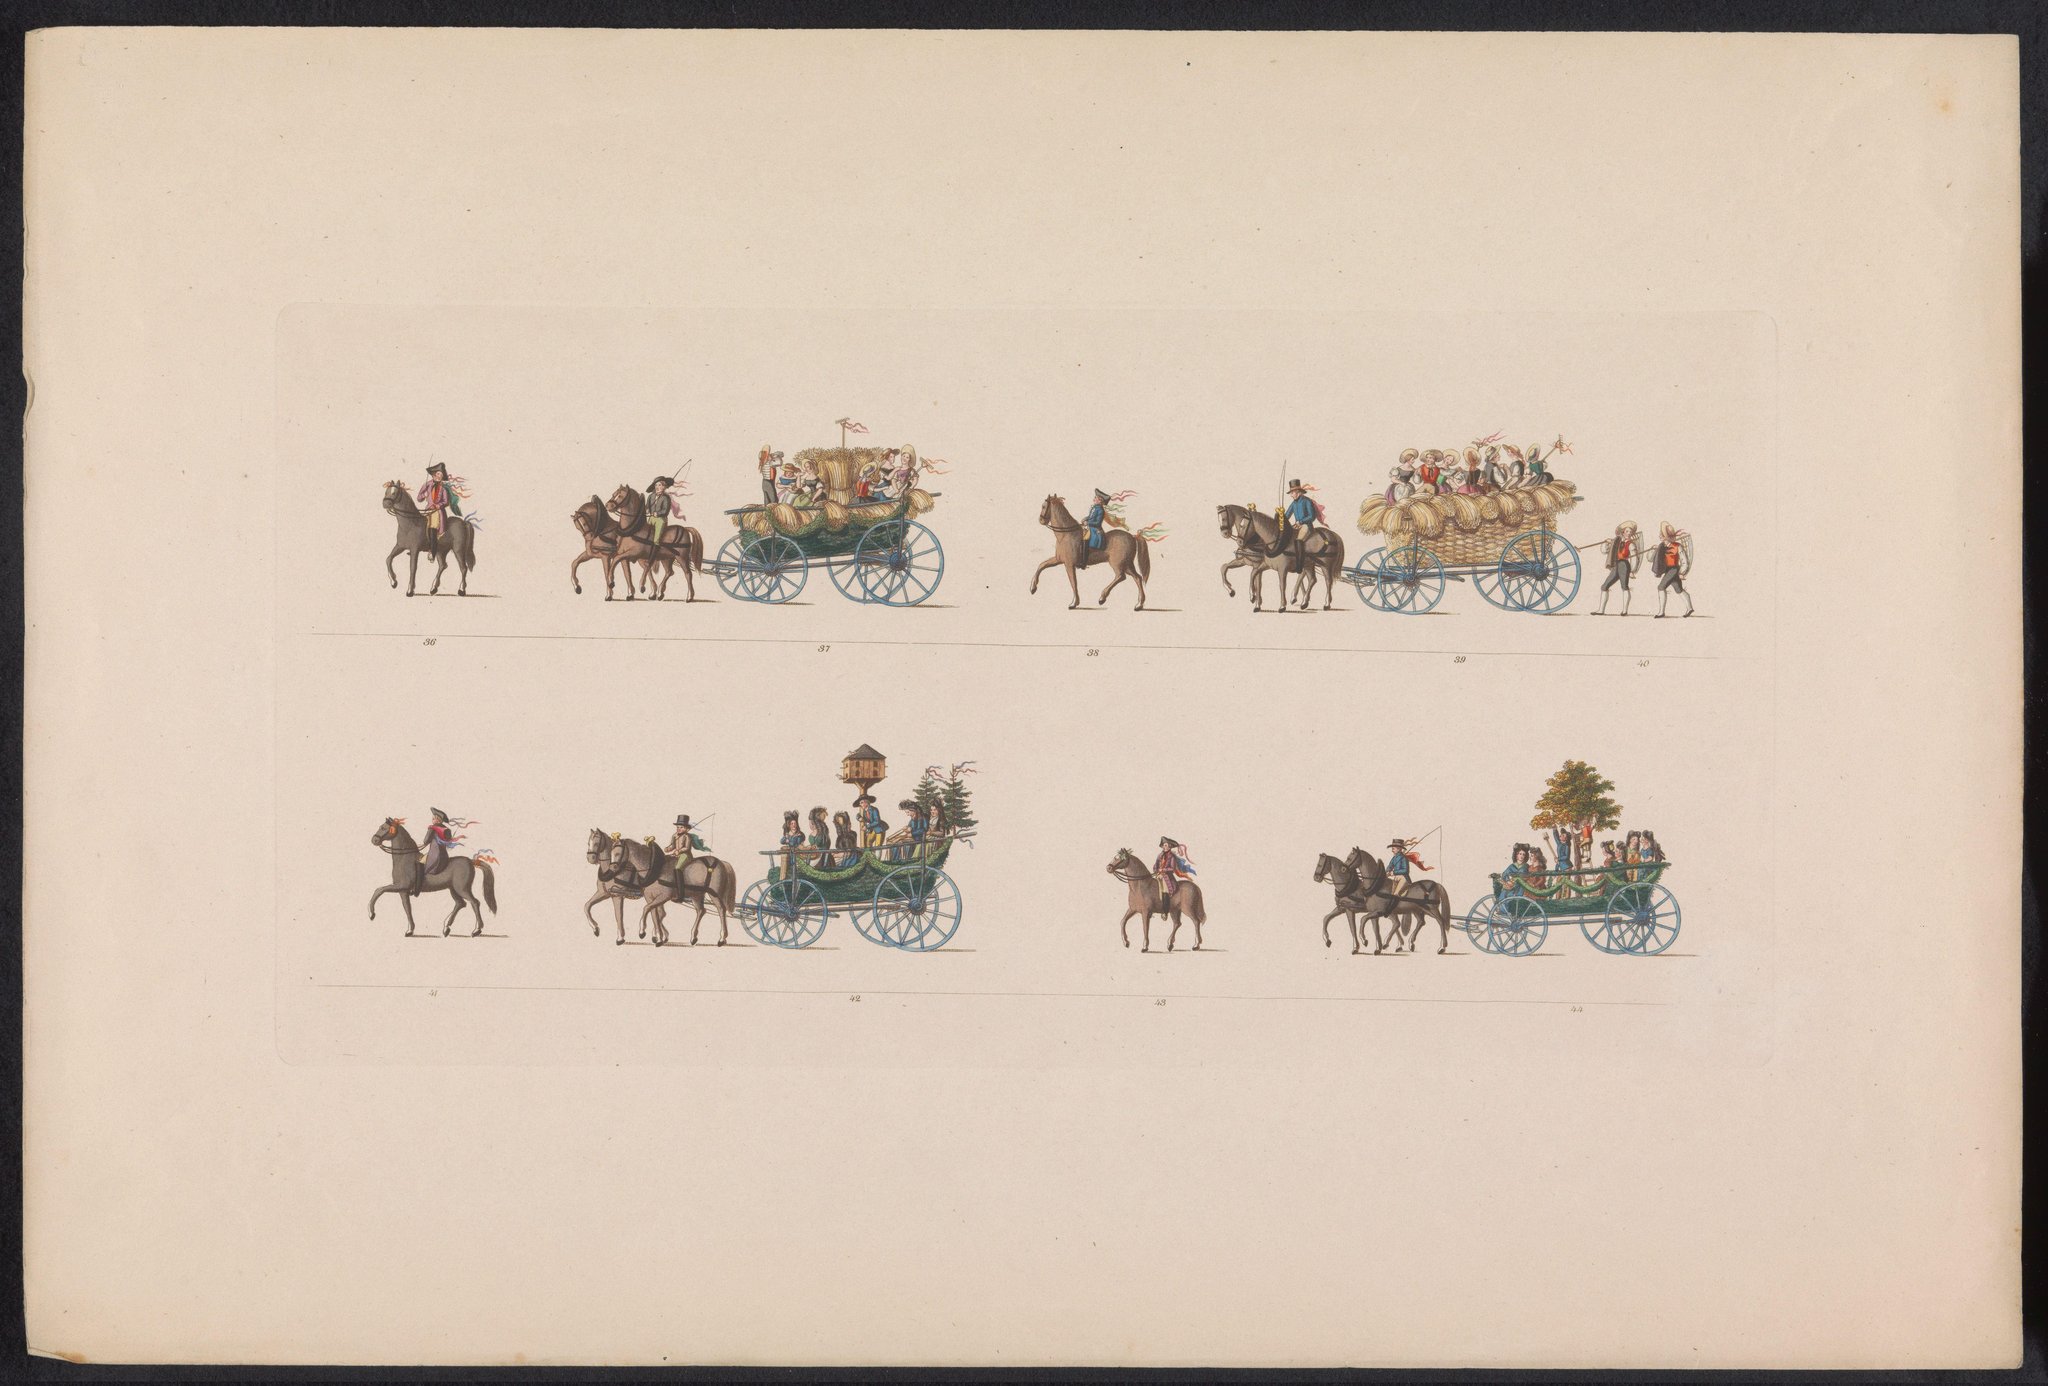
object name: print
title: Optocht bij het huwelijk van Prinses Sophie, 1842 (plaat 5)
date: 1842-1843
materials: paper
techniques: etching, hand coloring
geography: weimar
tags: public festivities at marriage of royal persons (+ parade, pageant, cavalcade ~ festive activities)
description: Optocht ter gelegenheid van het huwelijk van Prinses Sophie met Karel Alexander, groothertog van Saksen-Weimar-Eisenach, gehouden bij de intocht van het paar te Weimar op 27 oktober 1842. Vijfde plaat met de groepen genummerd 36-44. Onderdeel van de serie van zes losse platen van de optocht.